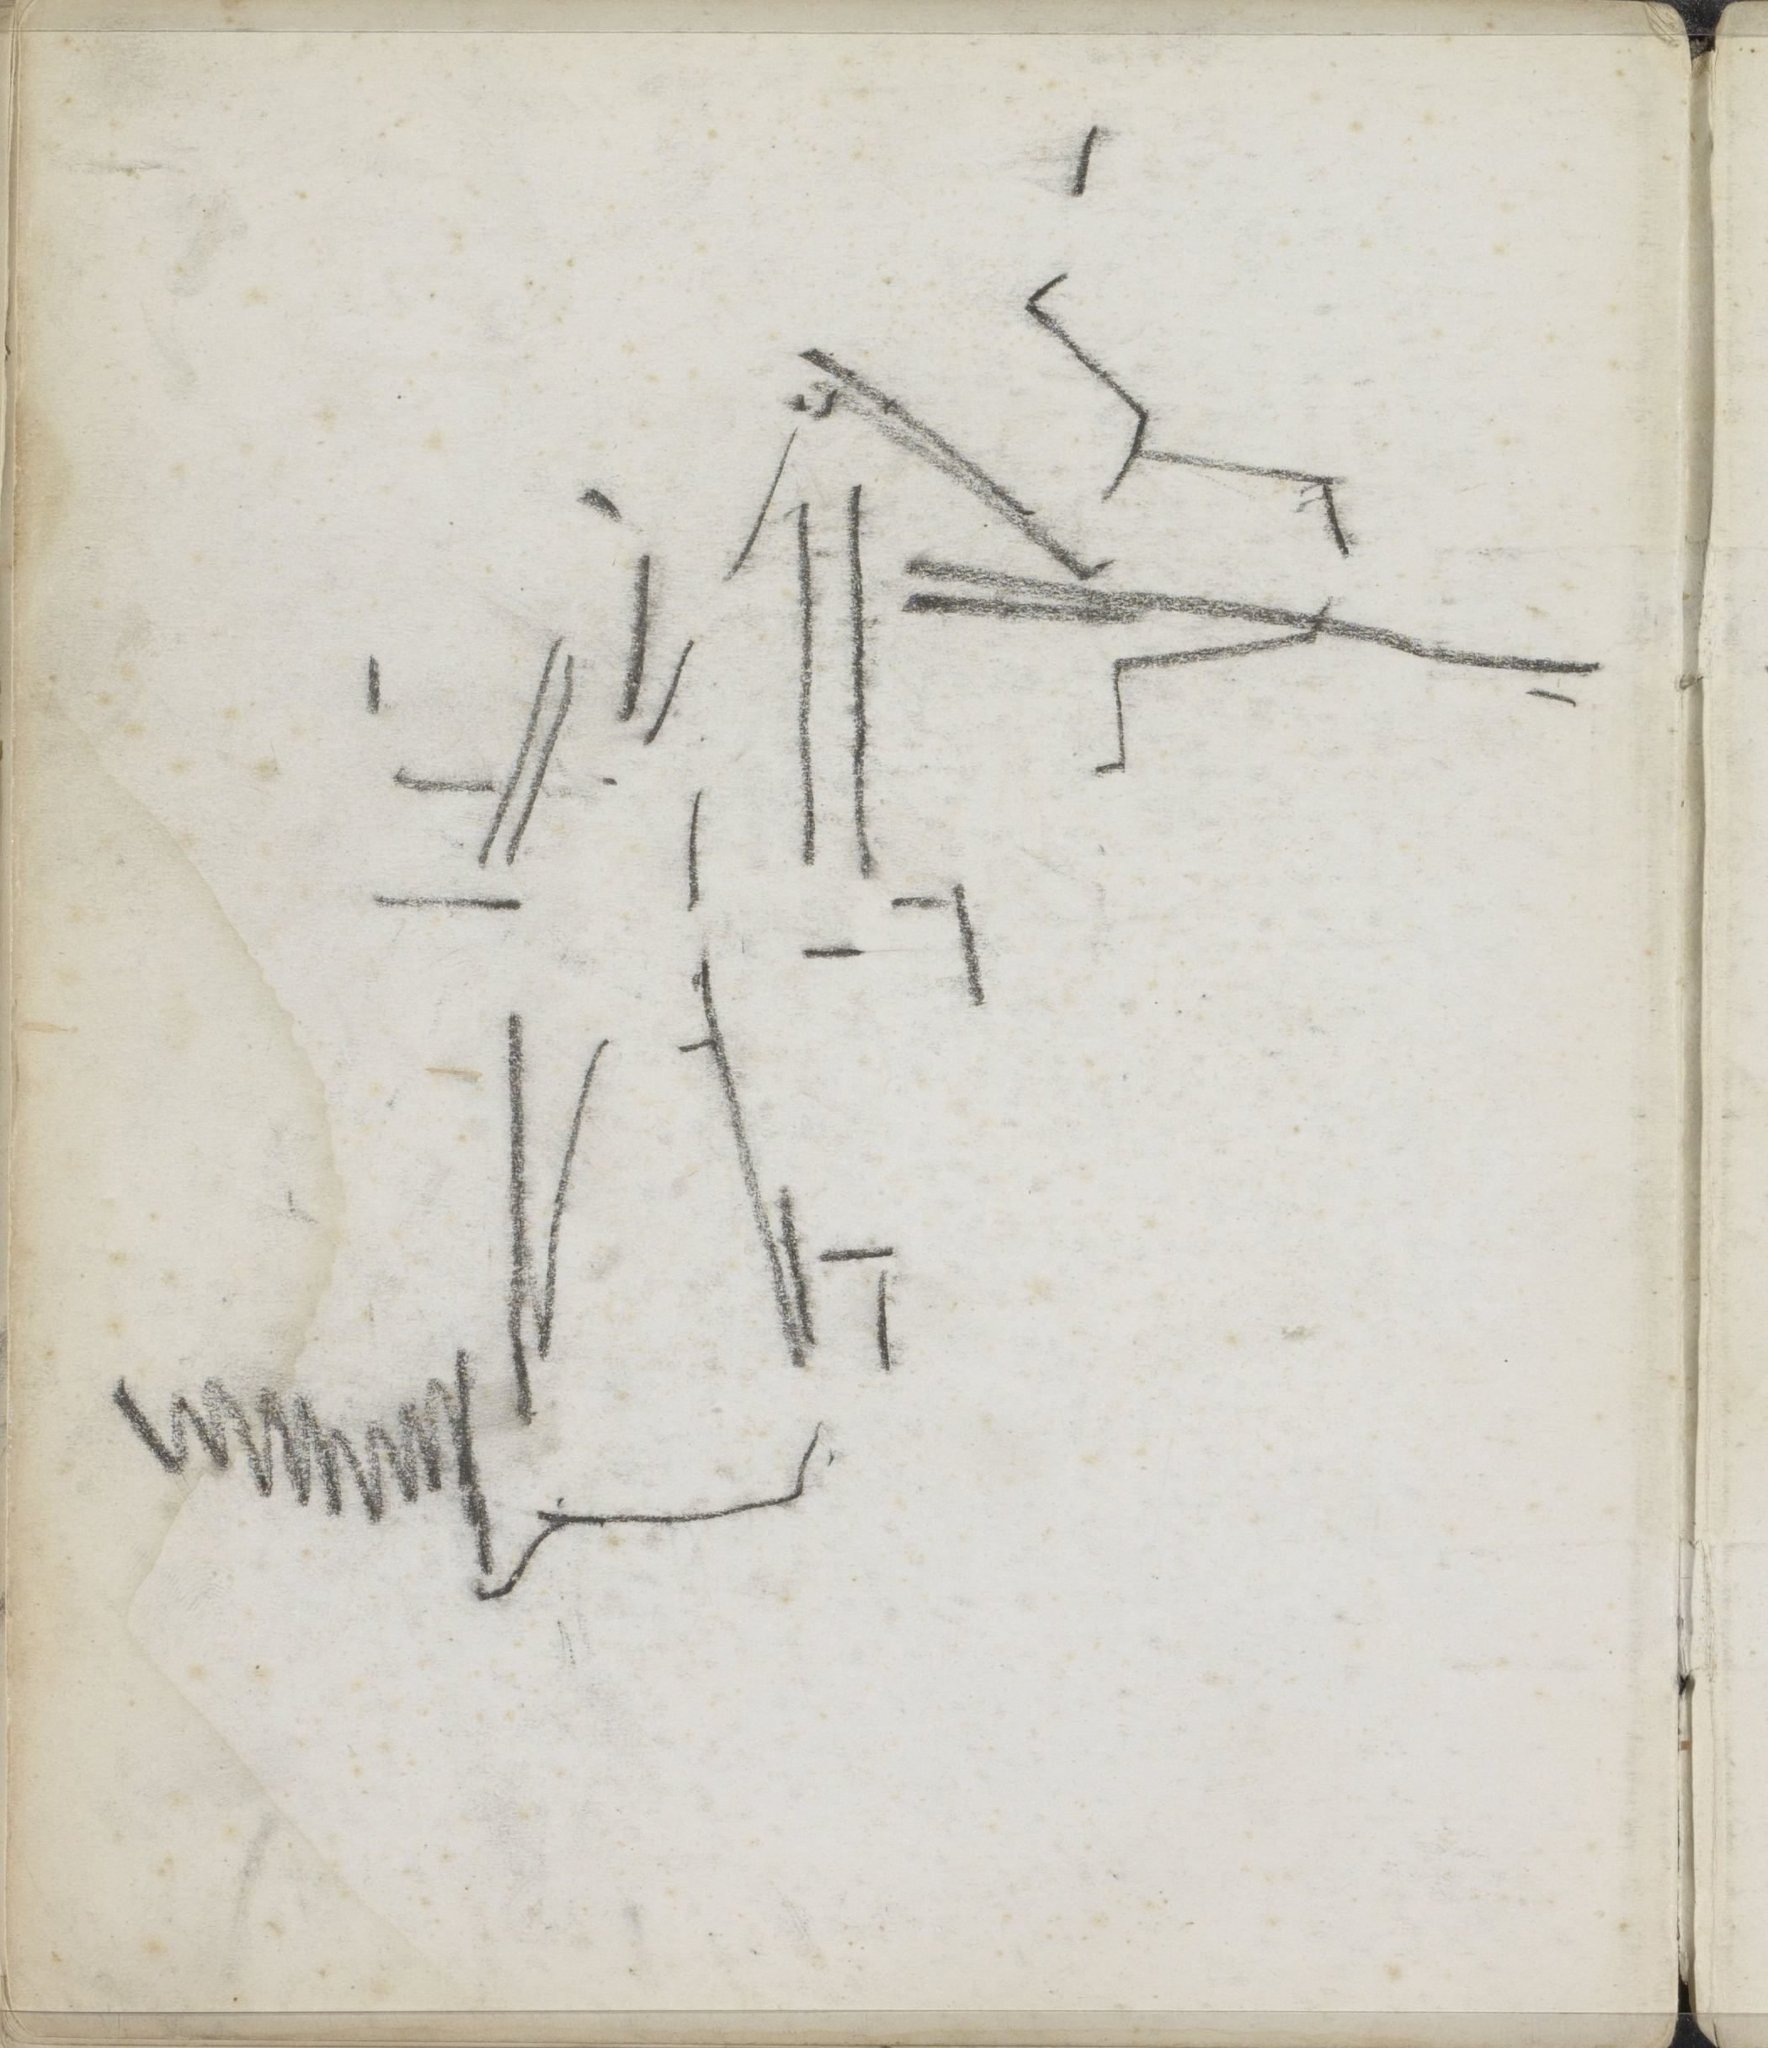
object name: sketchbook leaf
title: Bebouwing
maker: george hendrik breitner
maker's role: draughtsman, painter, print maker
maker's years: 1857-1923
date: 1880-1906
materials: chalk, paper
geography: netherlands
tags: civic architecture; edifices; dwellings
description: Pagina 163 uit een schetsboek met 81 bladen.